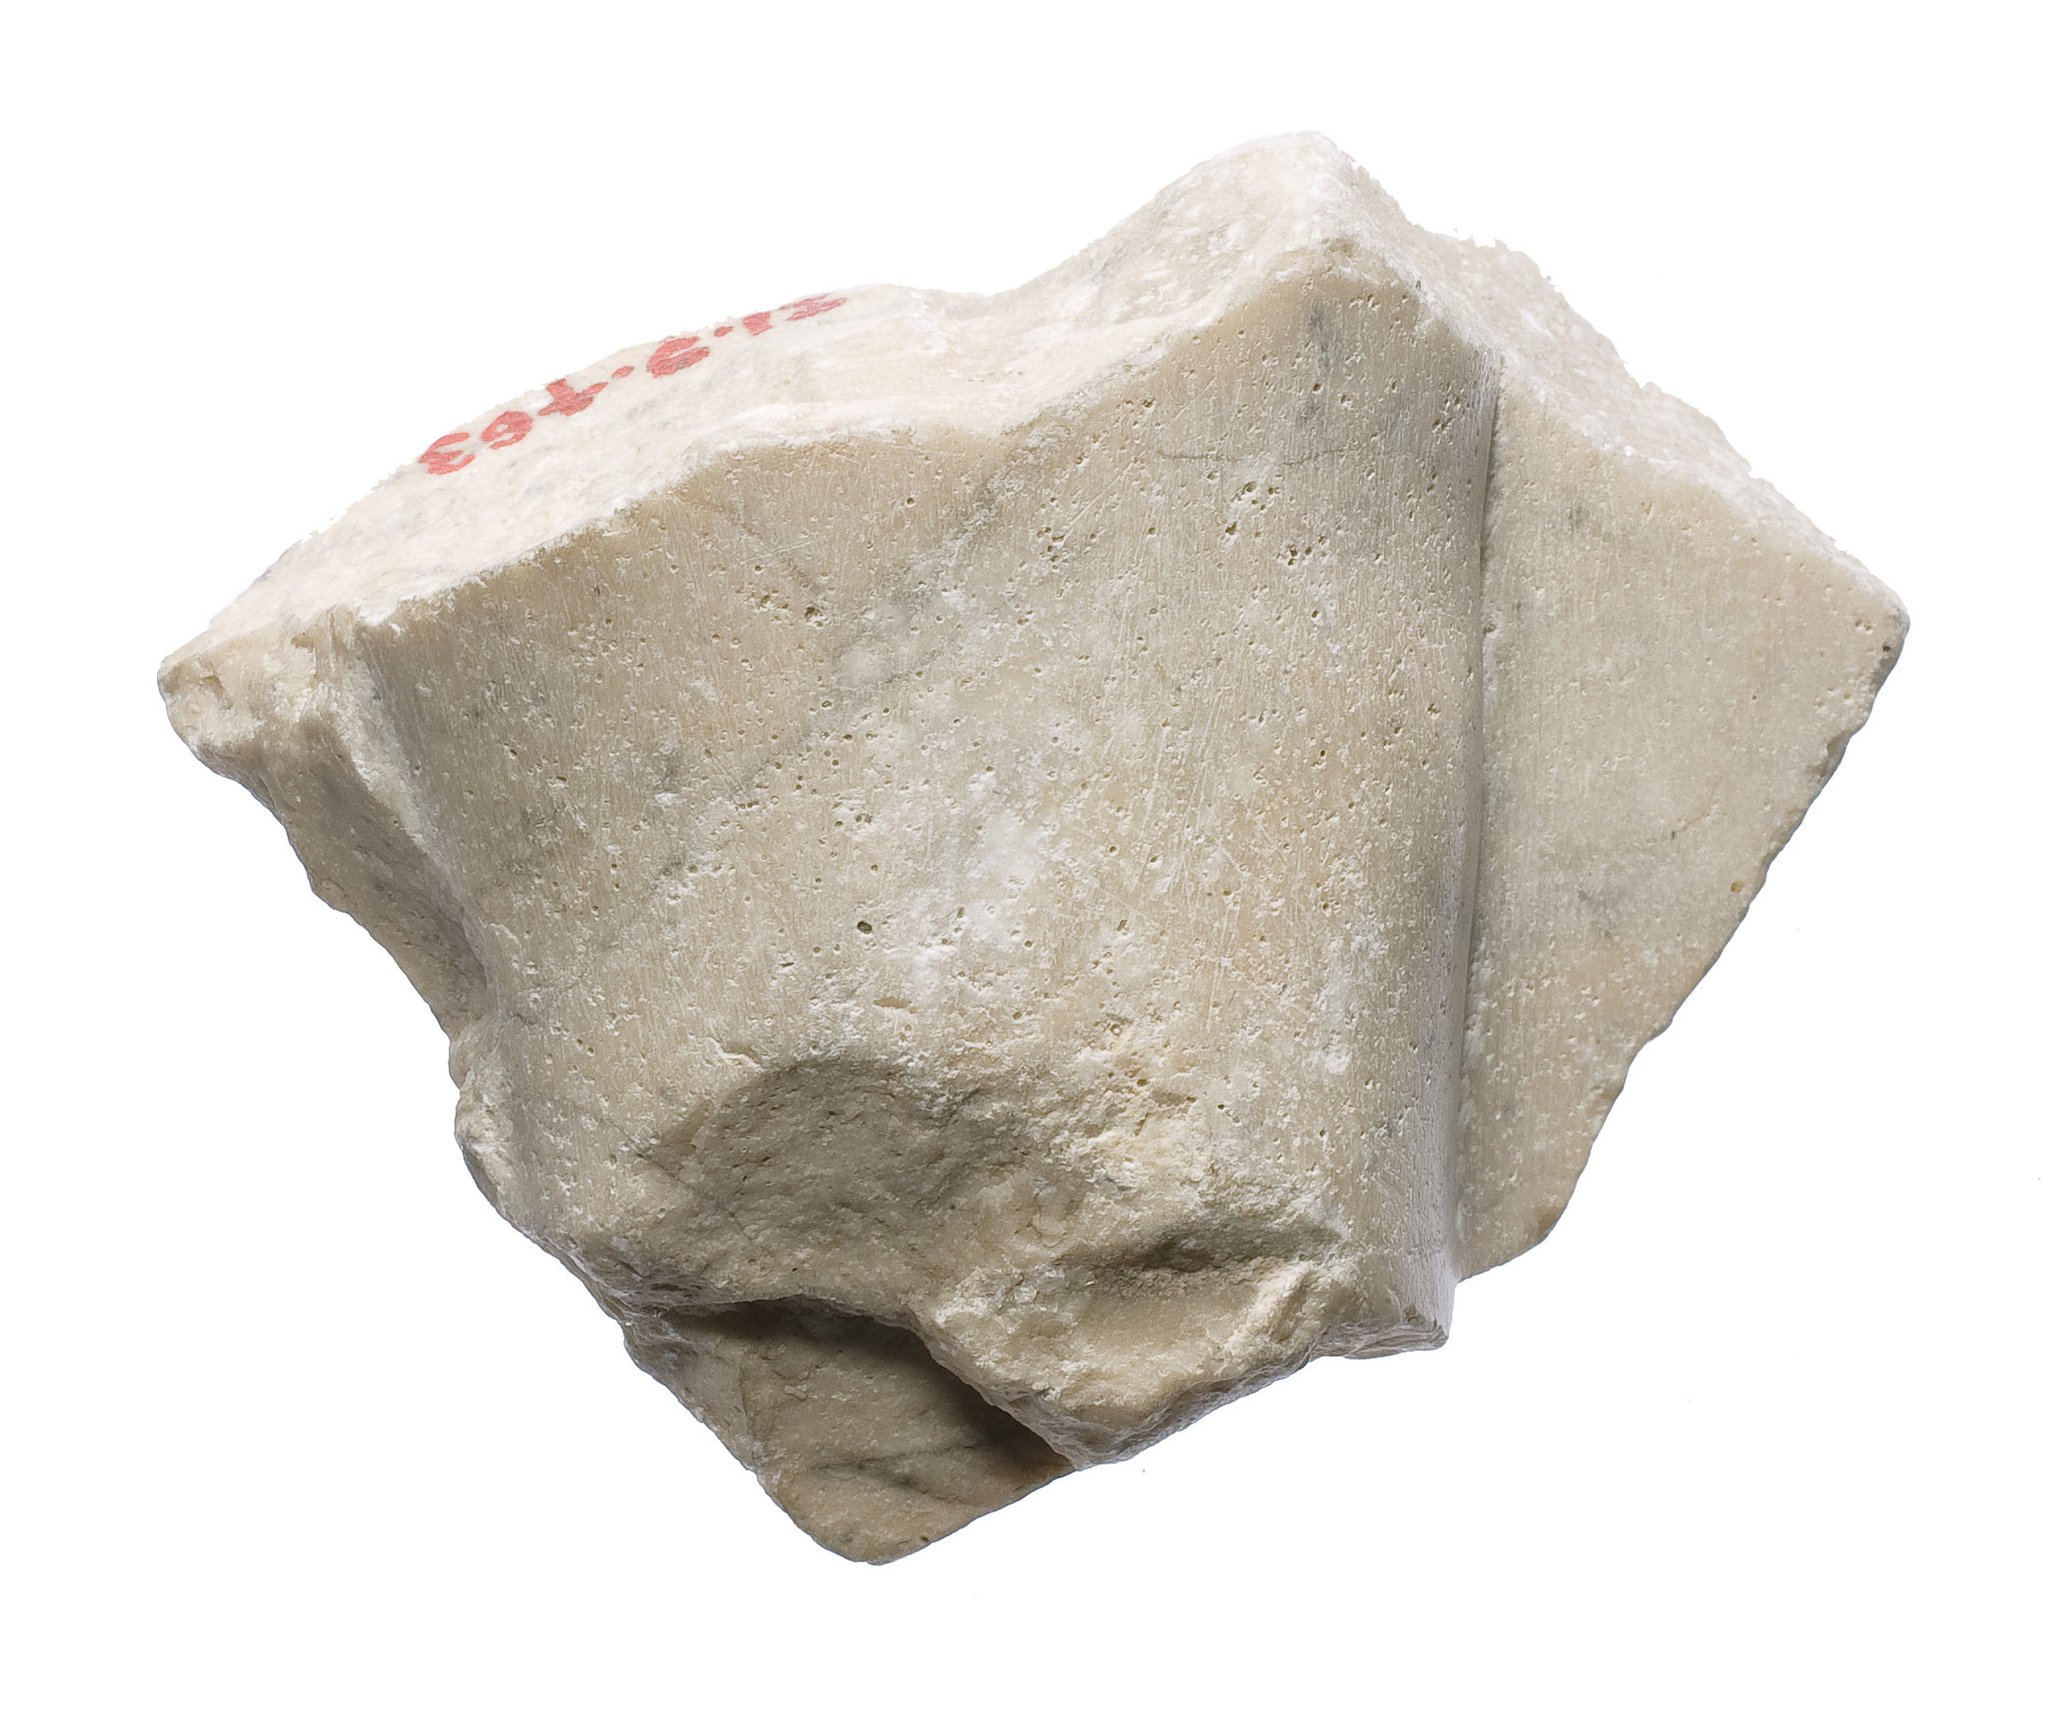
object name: wrist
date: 1353-1336 BCE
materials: limestone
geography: egypt